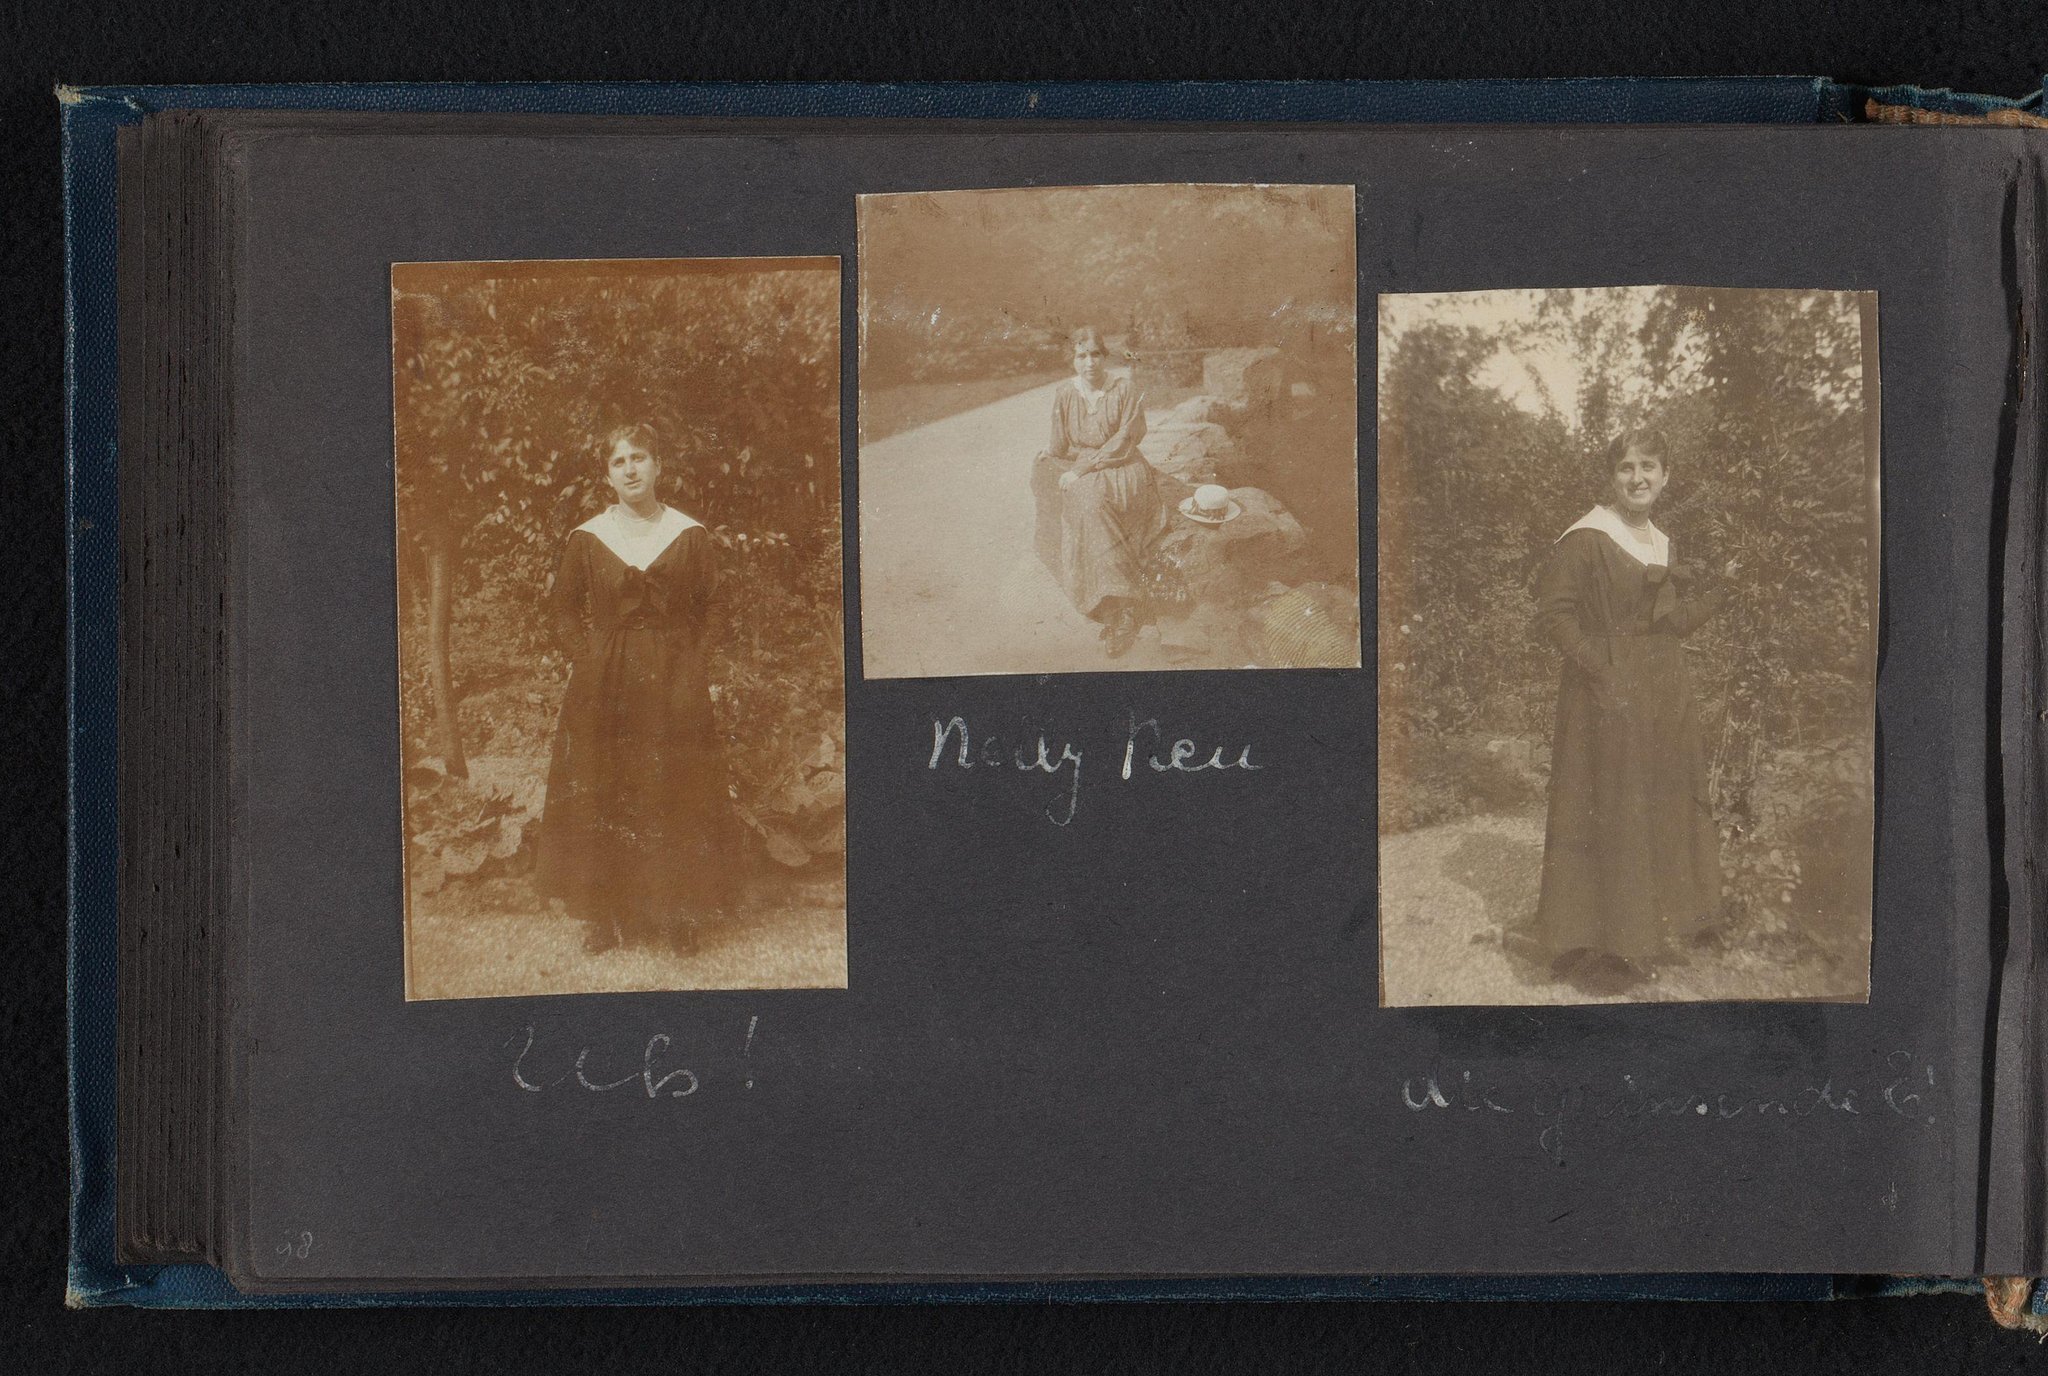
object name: album leaf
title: Else en vriendin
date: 1916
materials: paper, photographic support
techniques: collodion silver print, gelatin silver print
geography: germany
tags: else wachenheimer-moos, historical persons - bb - woman, germany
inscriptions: inscription: ‘Ich! / Nelly Neu / ...’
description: Albumblad met drie foto's van Else en een vriendin. Onderdeel van het fotoalbum van Else Wachenheimer-Moos en haar broers Arthur en Willy Moos en anderen in de periode 1913-1918.